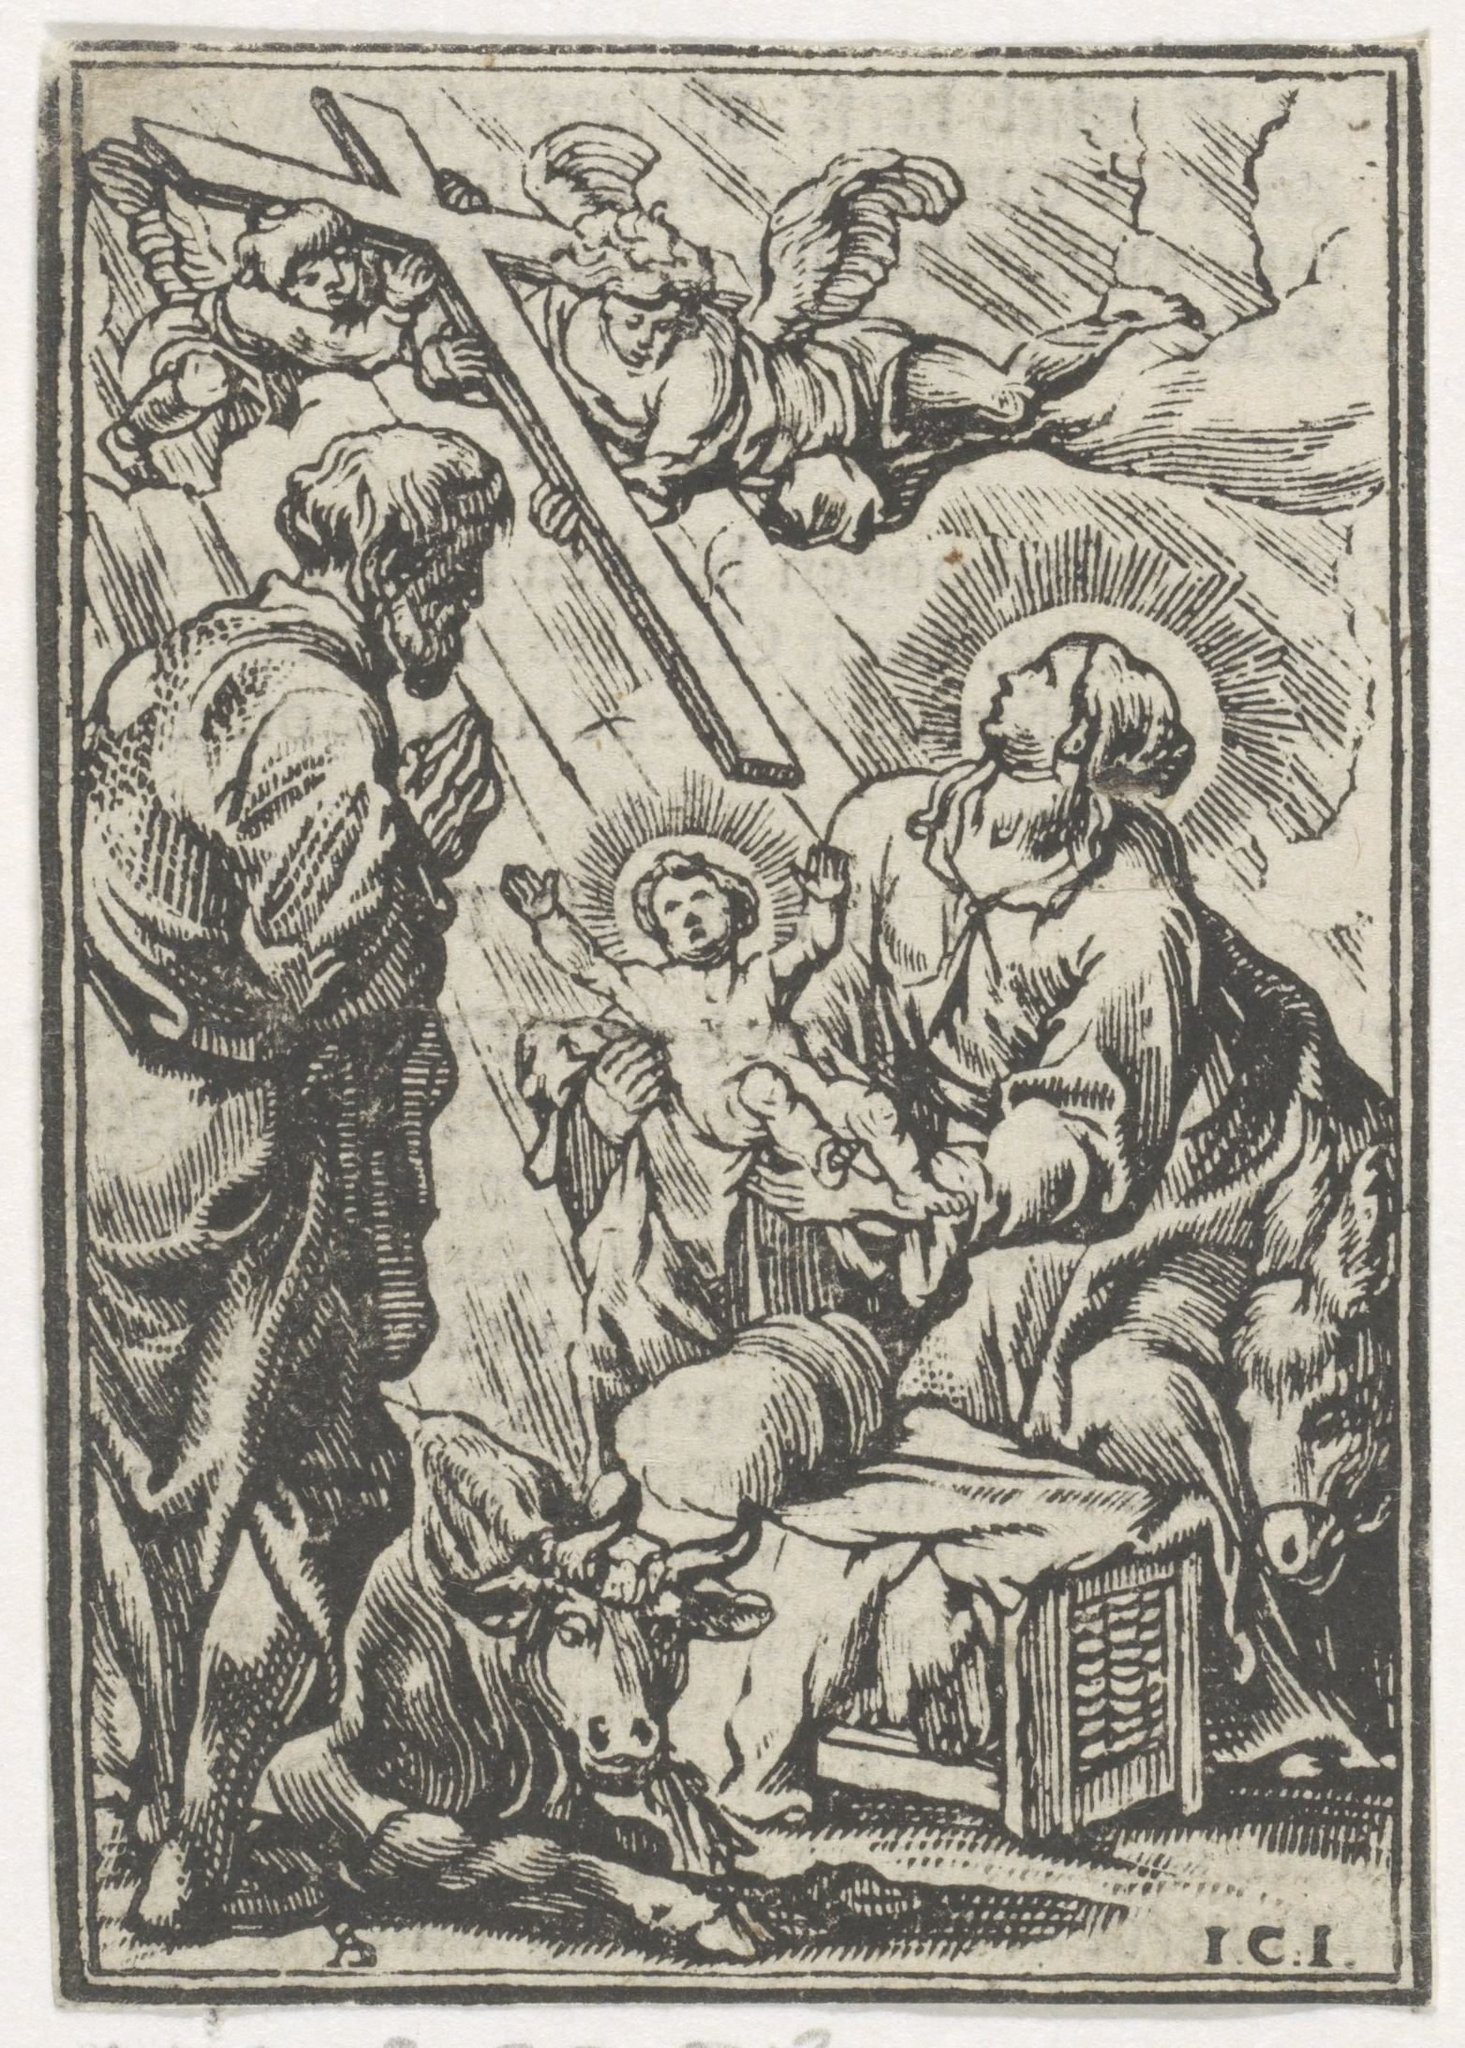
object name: book illustration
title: Geboorte van Christus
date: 1649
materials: paper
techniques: letterpress printing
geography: antwerp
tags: mary, joseph and the new-born christ (nativity)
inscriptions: collector's mark: Lugt 2228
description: Maria staat met het Christuskind in haar armen in de stal met de os en de ezel. Jozef staat naast de kribbe te bidden. Twee engelen houden een groot kruis boven het Christuskind.